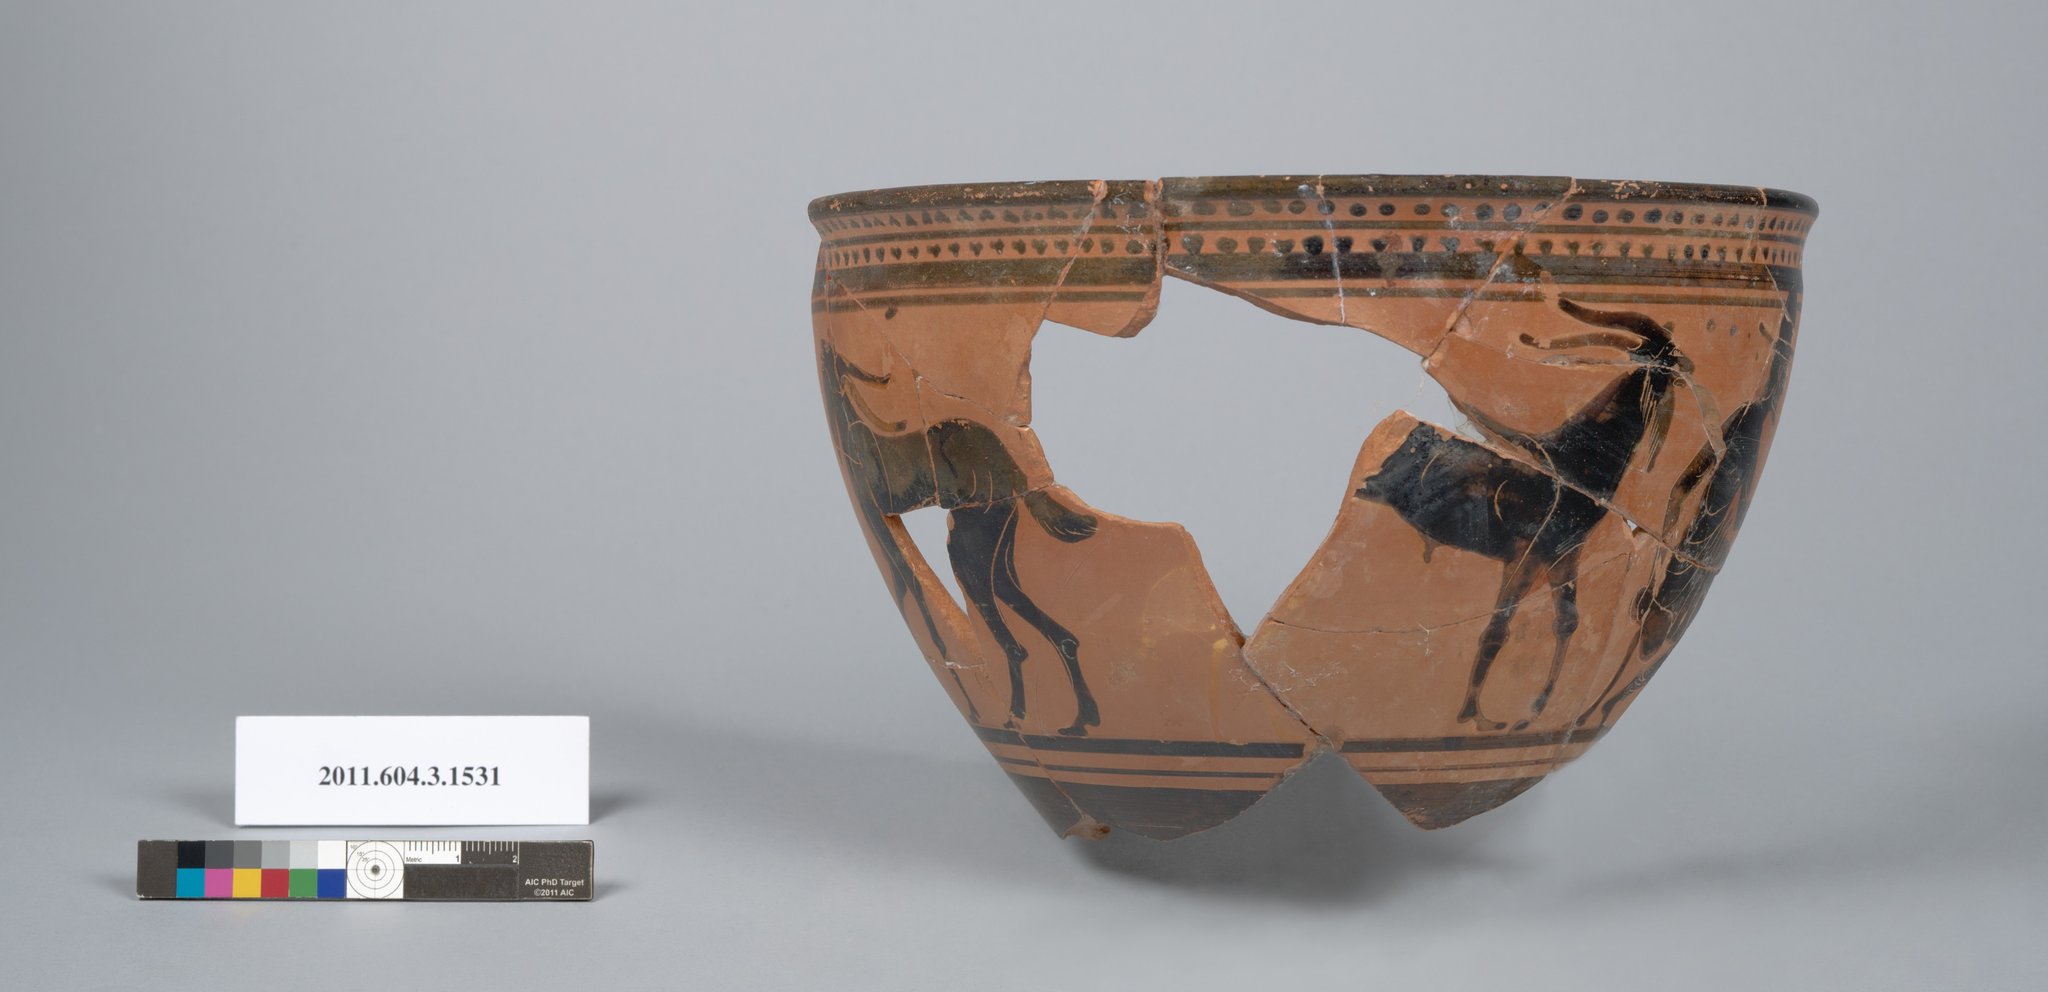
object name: skyphos fragment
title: Terracotta fragment of a skyphos (deep drinking cup)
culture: greek, attic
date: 534-468 BCE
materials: terracotta